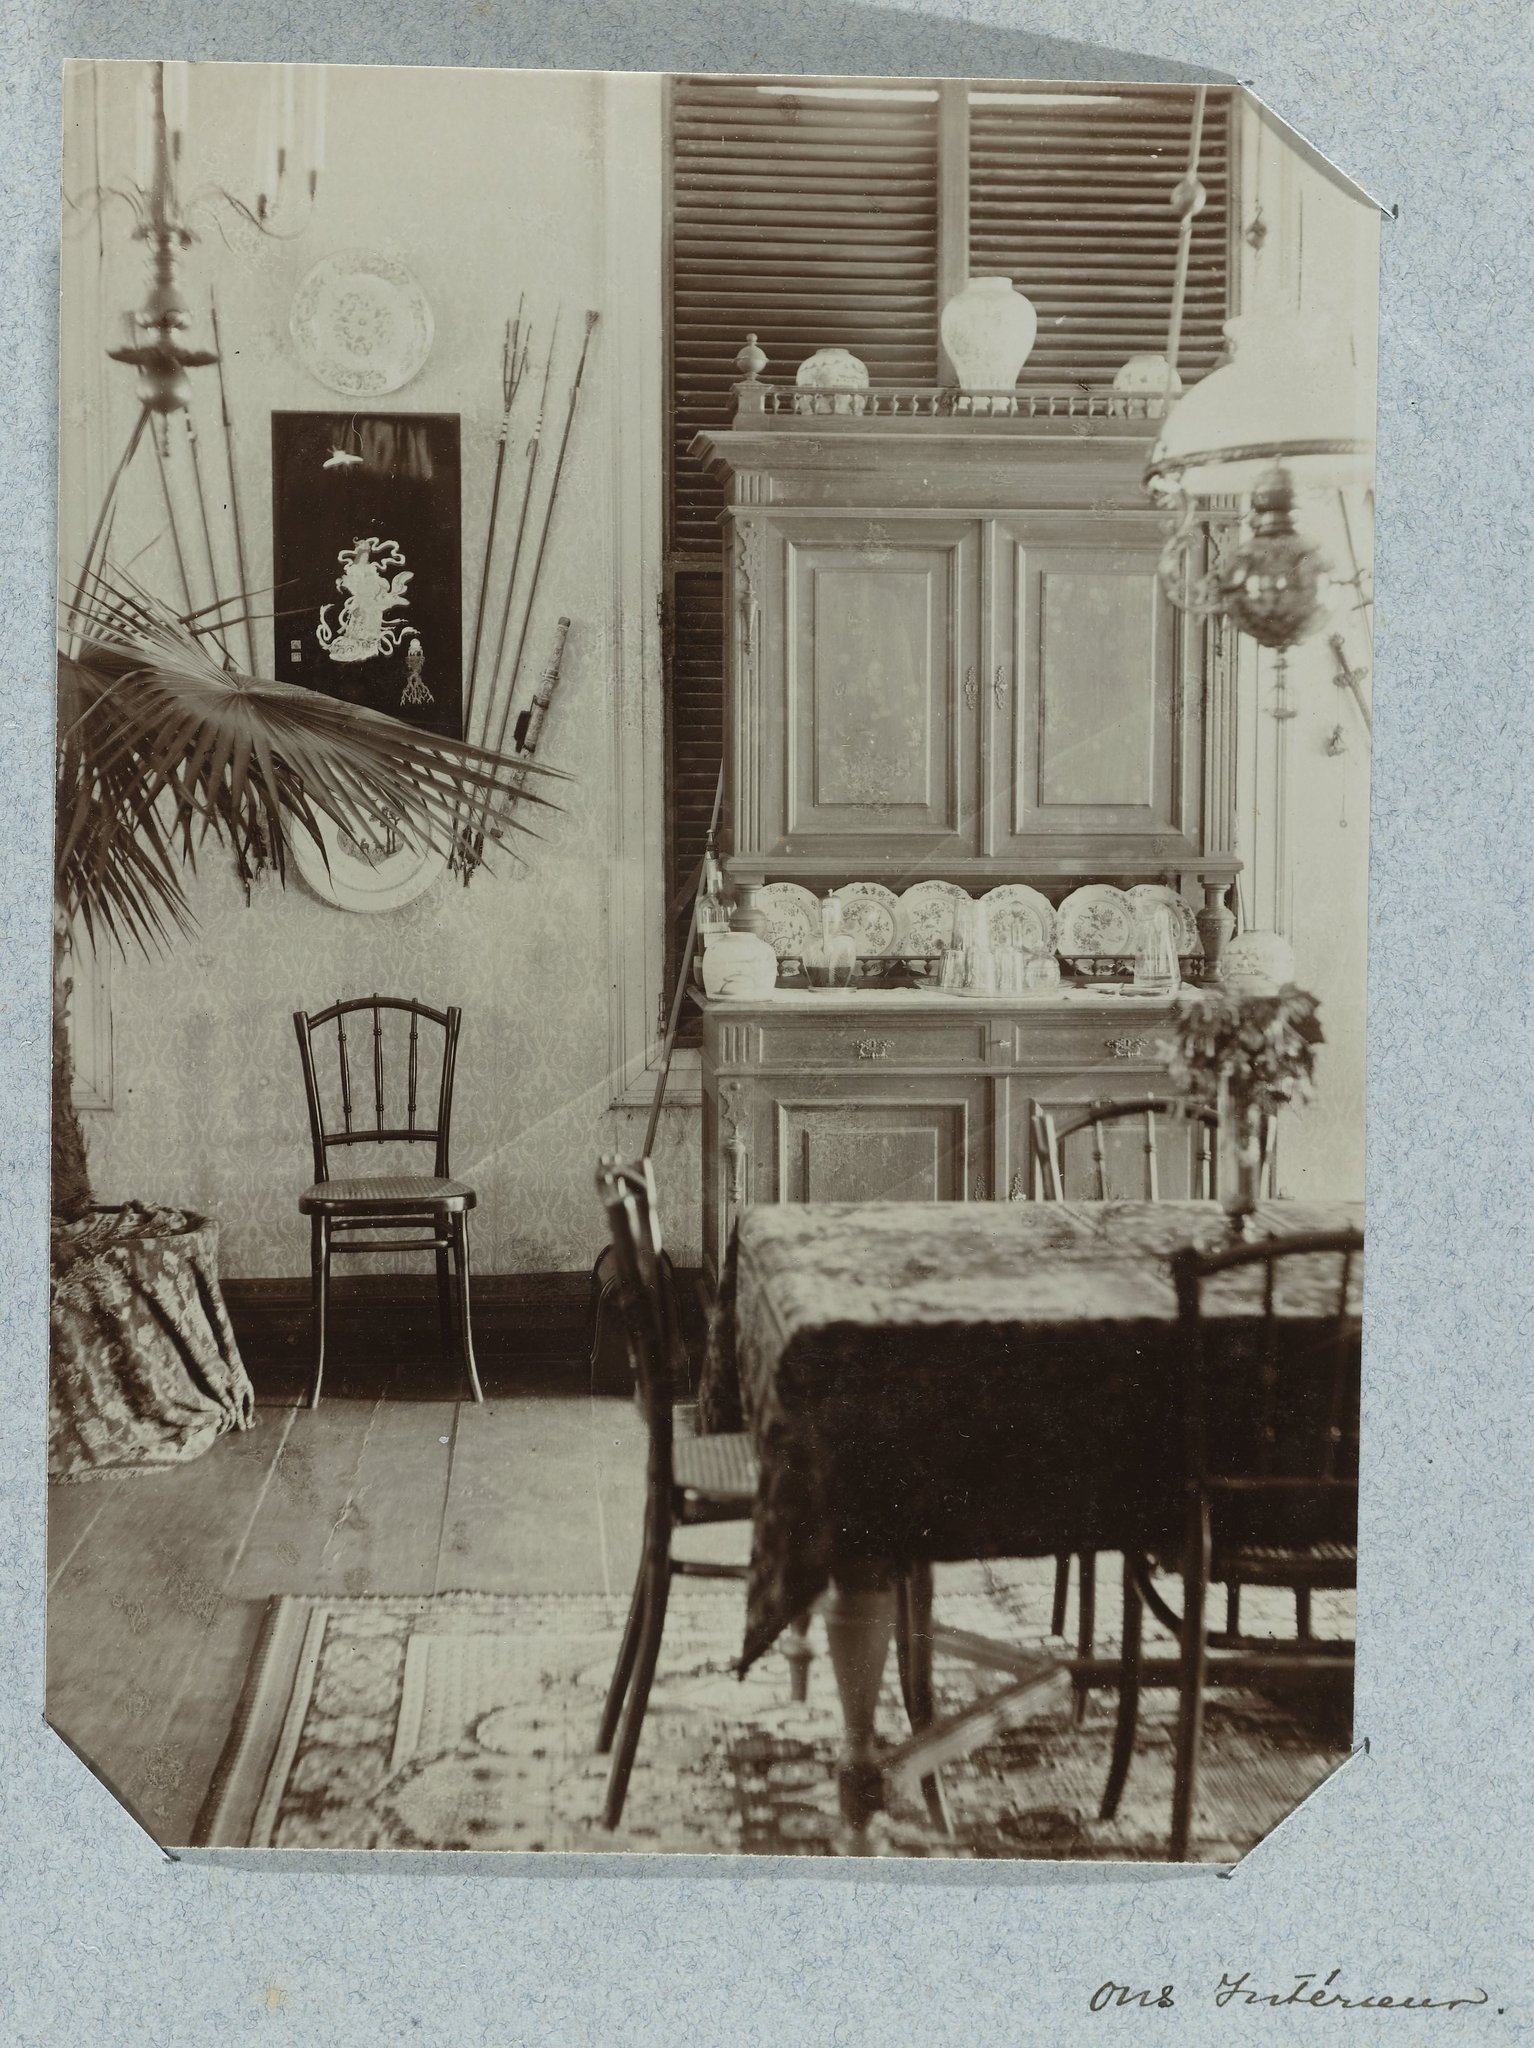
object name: photograph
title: Ons Intérieur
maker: théodore van lelyveld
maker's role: painter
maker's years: 1867-1954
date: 1895-1896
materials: photographic support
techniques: collodion silver print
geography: suriname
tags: communal rooms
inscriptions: inscription: ‘Ons Intérieur’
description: Interieur van het huis van het echtpaar Lelyveld aan de Gravenstraat te Paramaribo. Fotoafdruk in een fotoalbum van Théodore van Lelyveld over Suriname uit 1895-1898.